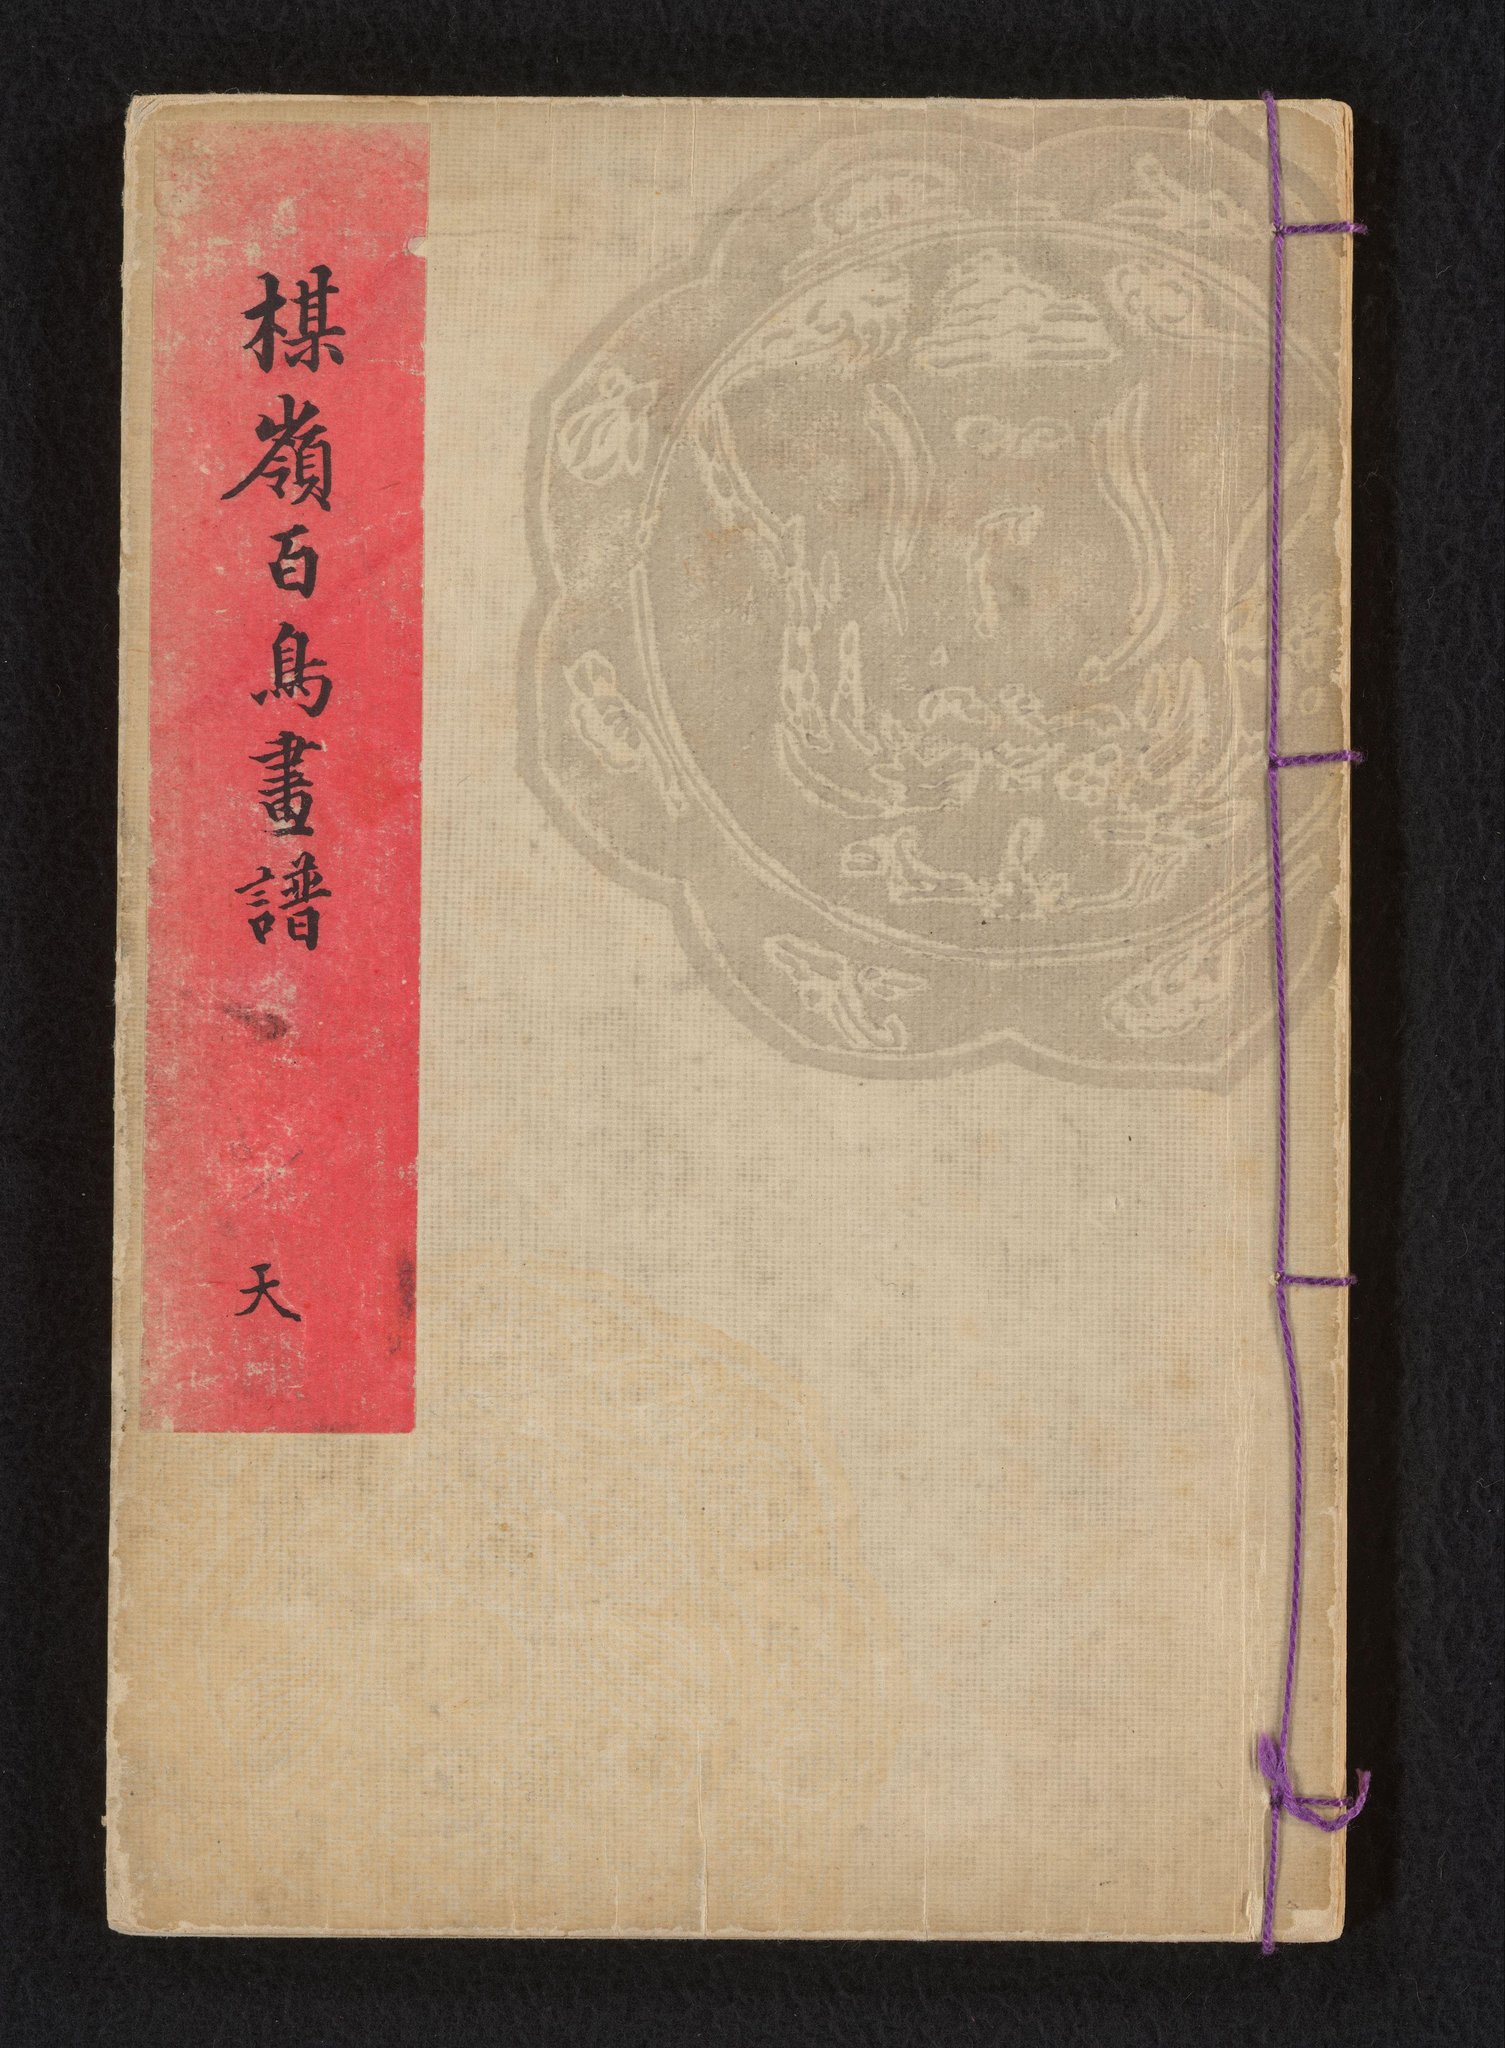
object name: book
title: Album met honderd vogels van Bairei, deel één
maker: kôno bairei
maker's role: painter, print maker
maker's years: 1844-1895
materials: paper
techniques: woodcut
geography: tokyo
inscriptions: collector's mark: Lugt 2228